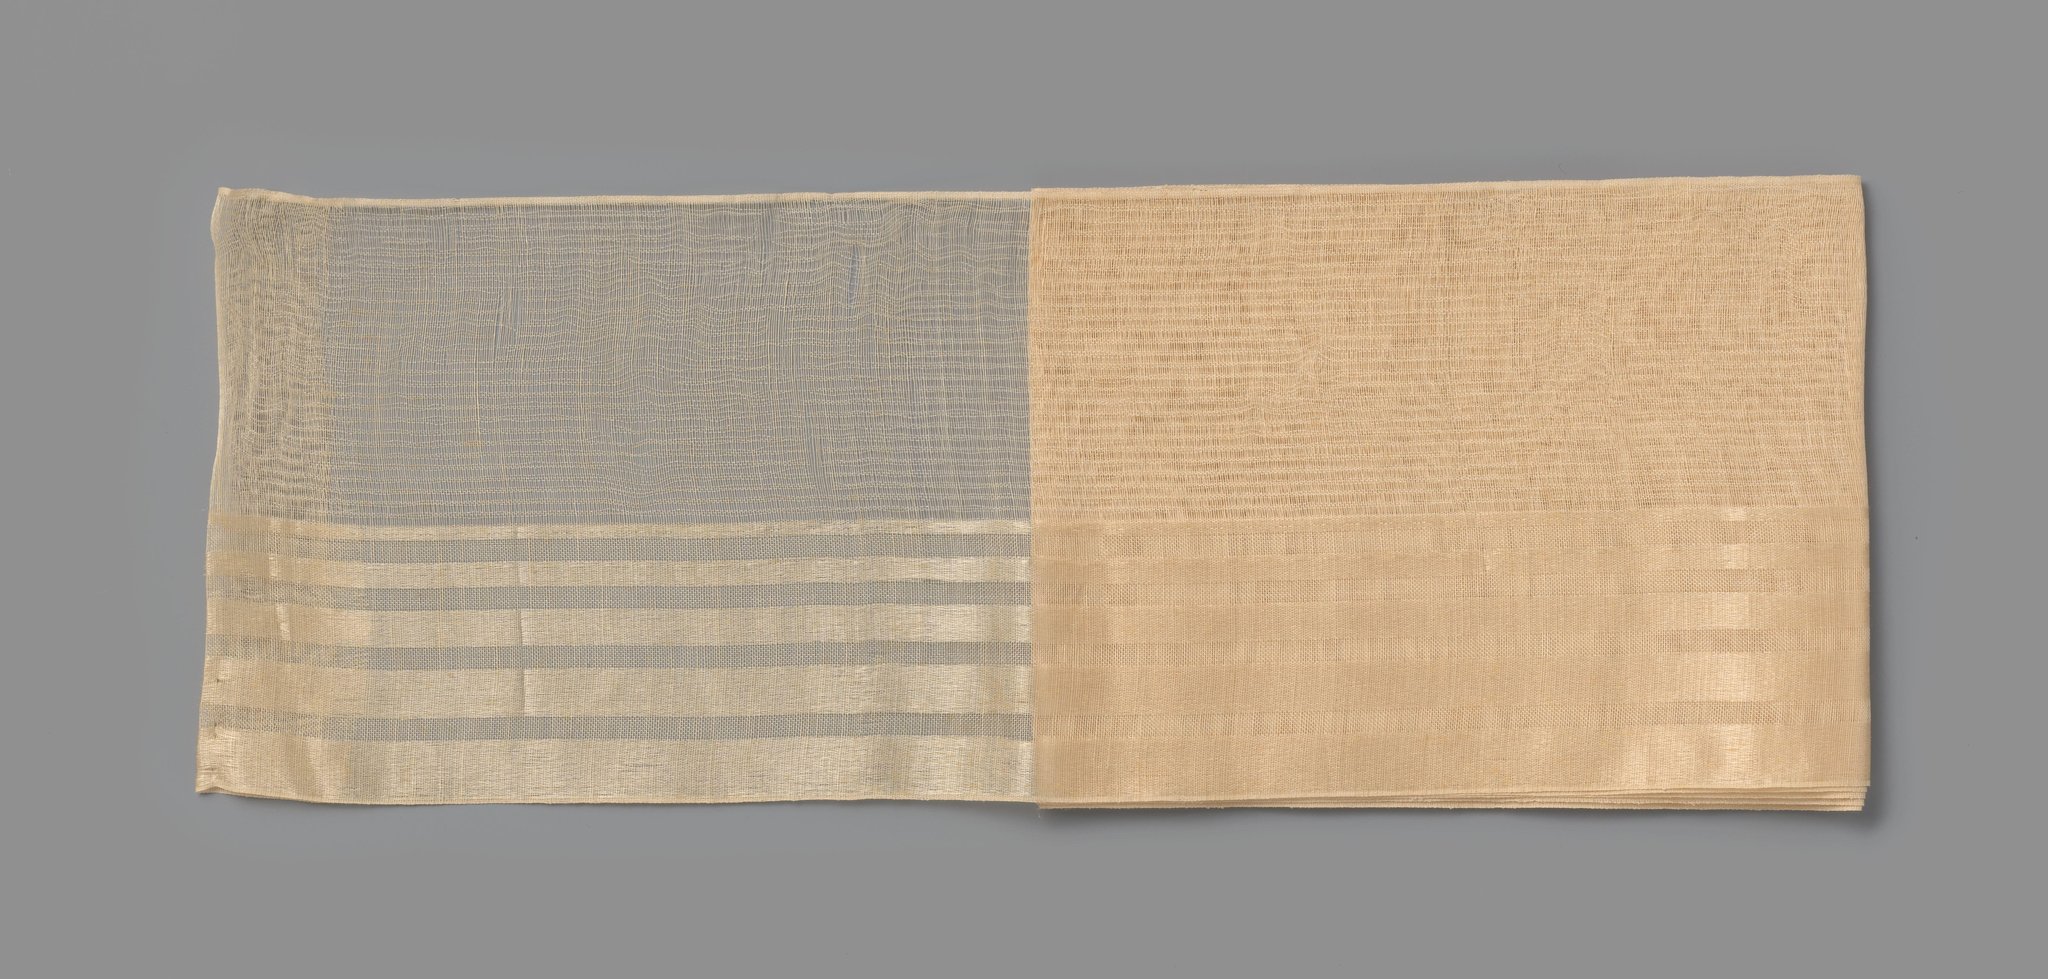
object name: ribbon material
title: Metrage van crème-wit lint van zijden gaas, waarvan de helft ingeweven banen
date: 1900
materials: silk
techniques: weave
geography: france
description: Metrage van crème-wit lint van zijden gaas, waarvan de helft ingeweven banen.